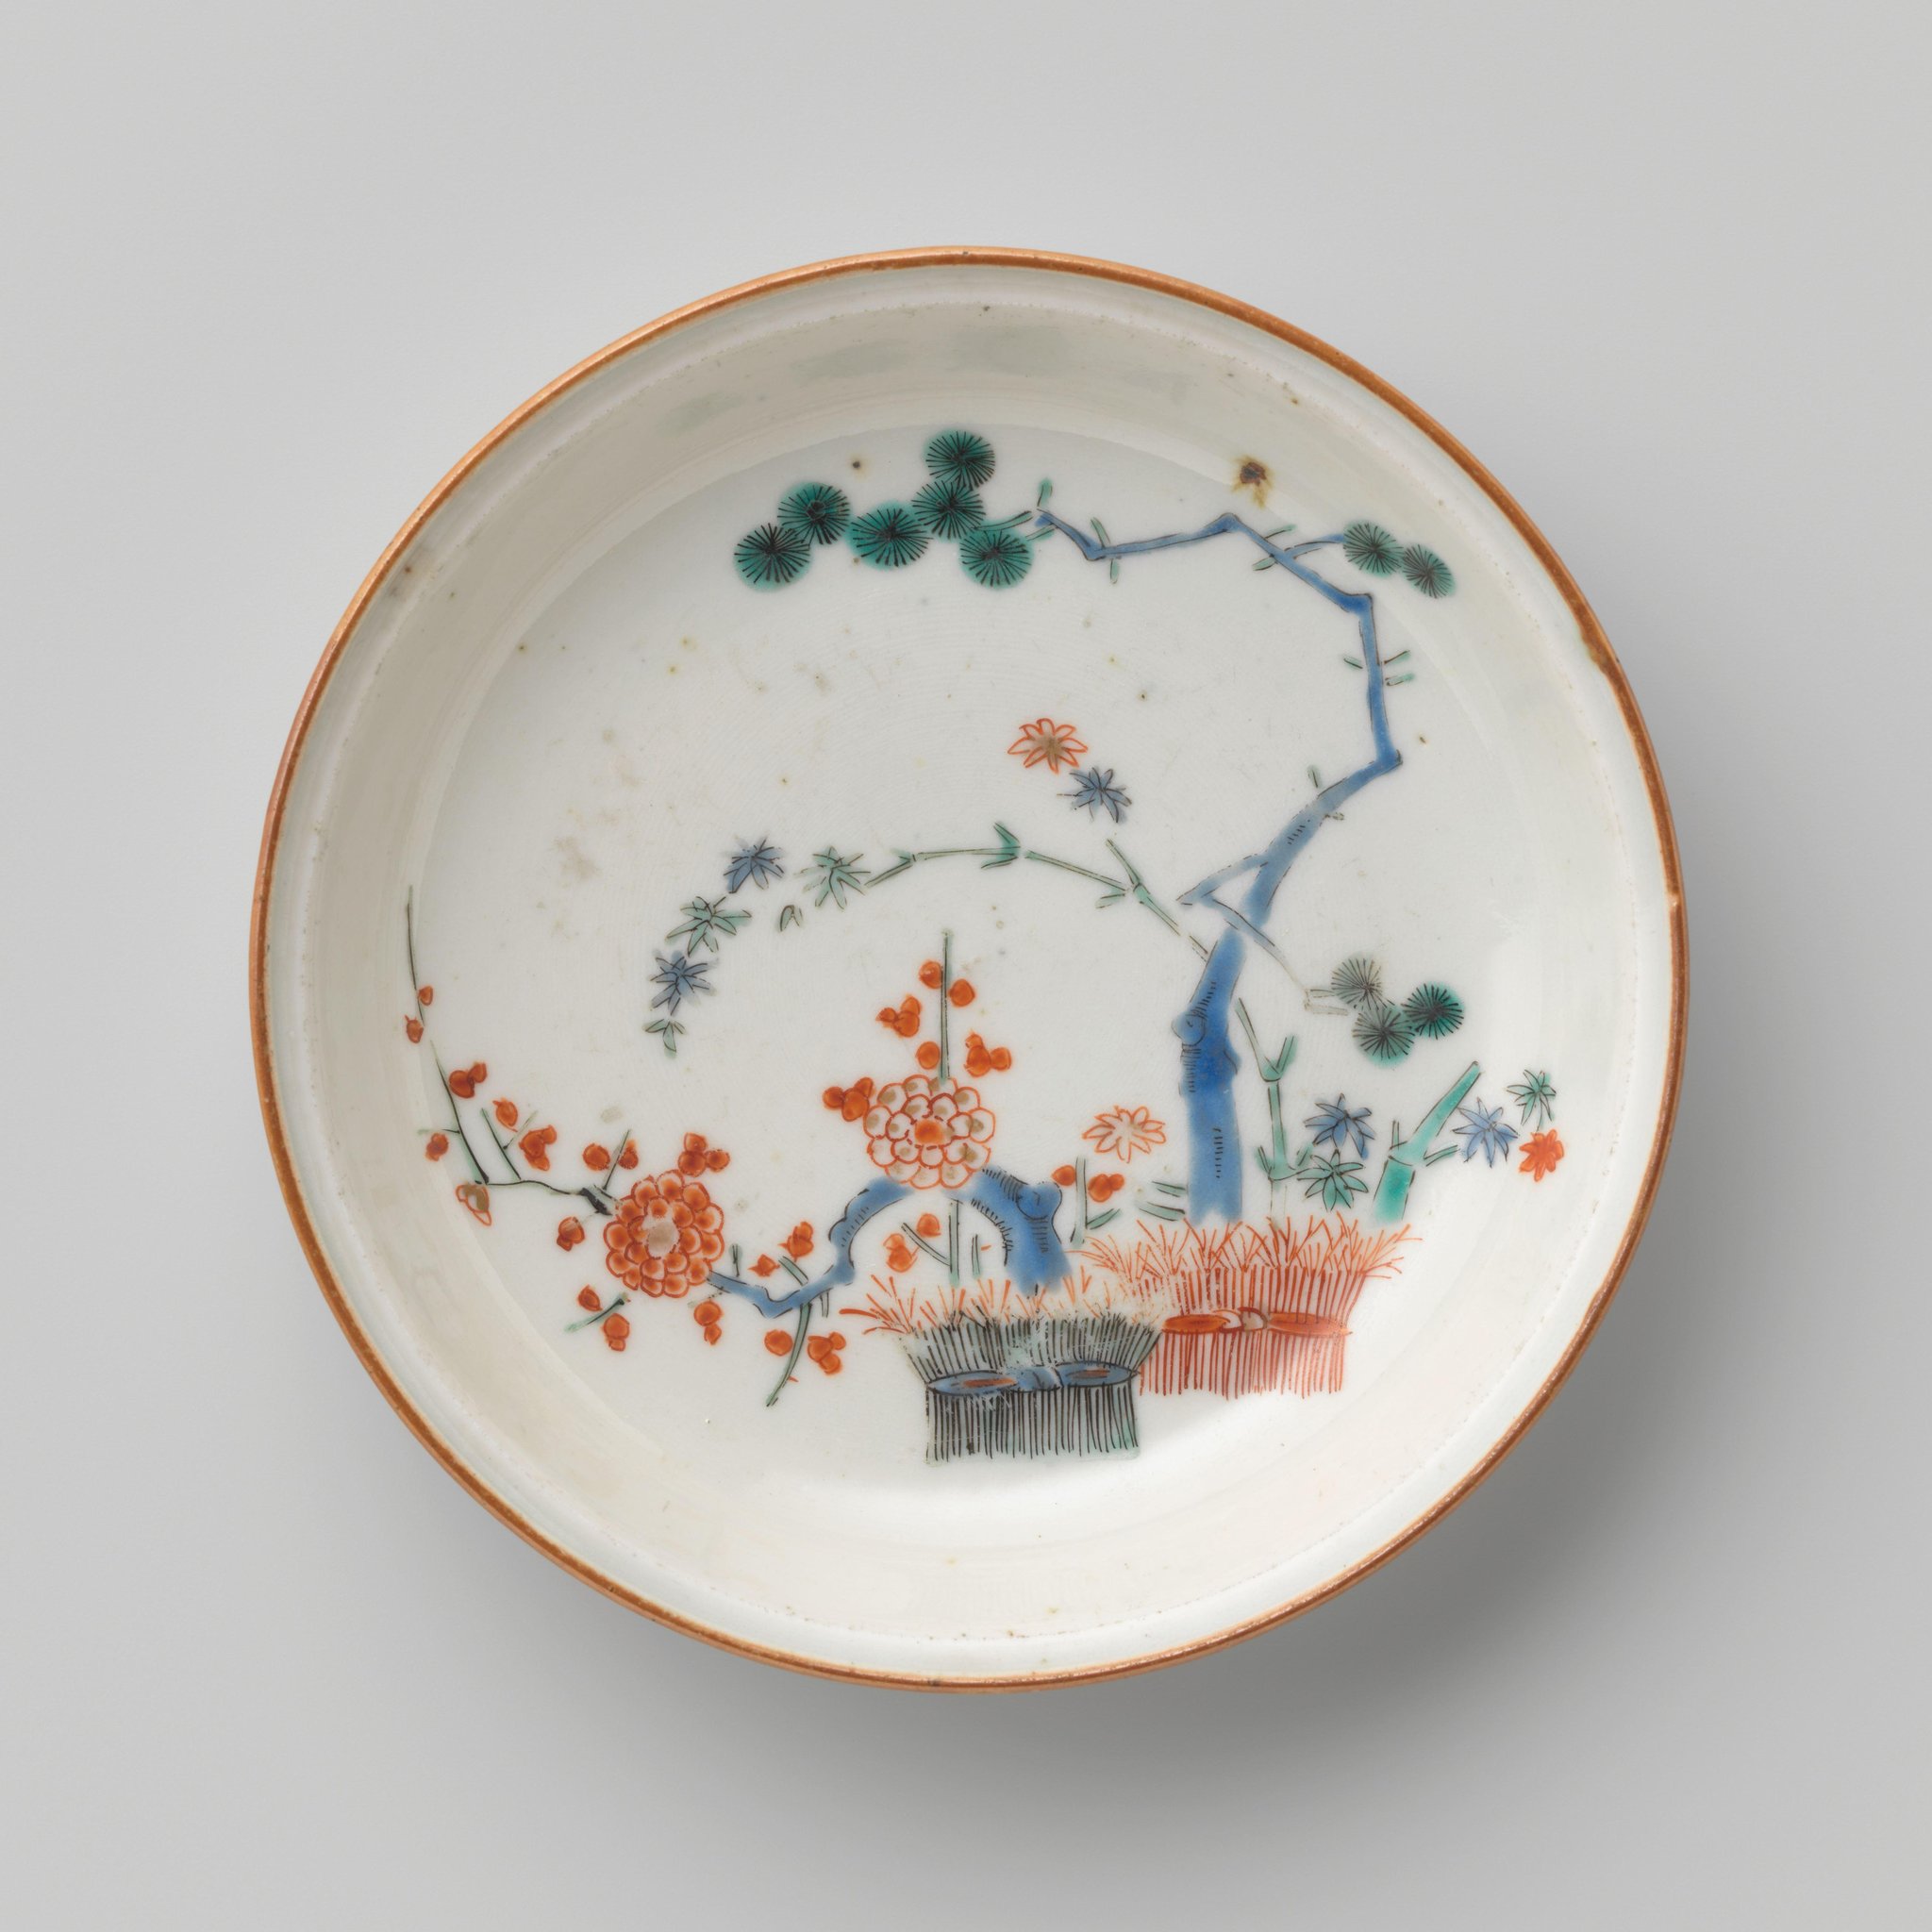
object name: platter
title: Round saucer with the 'three friends of winter'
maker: Anonymous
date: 1670-1700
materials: glaze, gold, paint, porcelain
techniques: firing, gilding, turning, vitrification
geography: japan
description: Ronde schotel van porselein, beschilderd op het glazuur in blauw, rood, groen, zwart en goud met de 'drie vrienden van de winter' (bamboe, prunus, pijnboom), bij twee gebonden heggen. Bruine rand. Kakiemon-stijl.